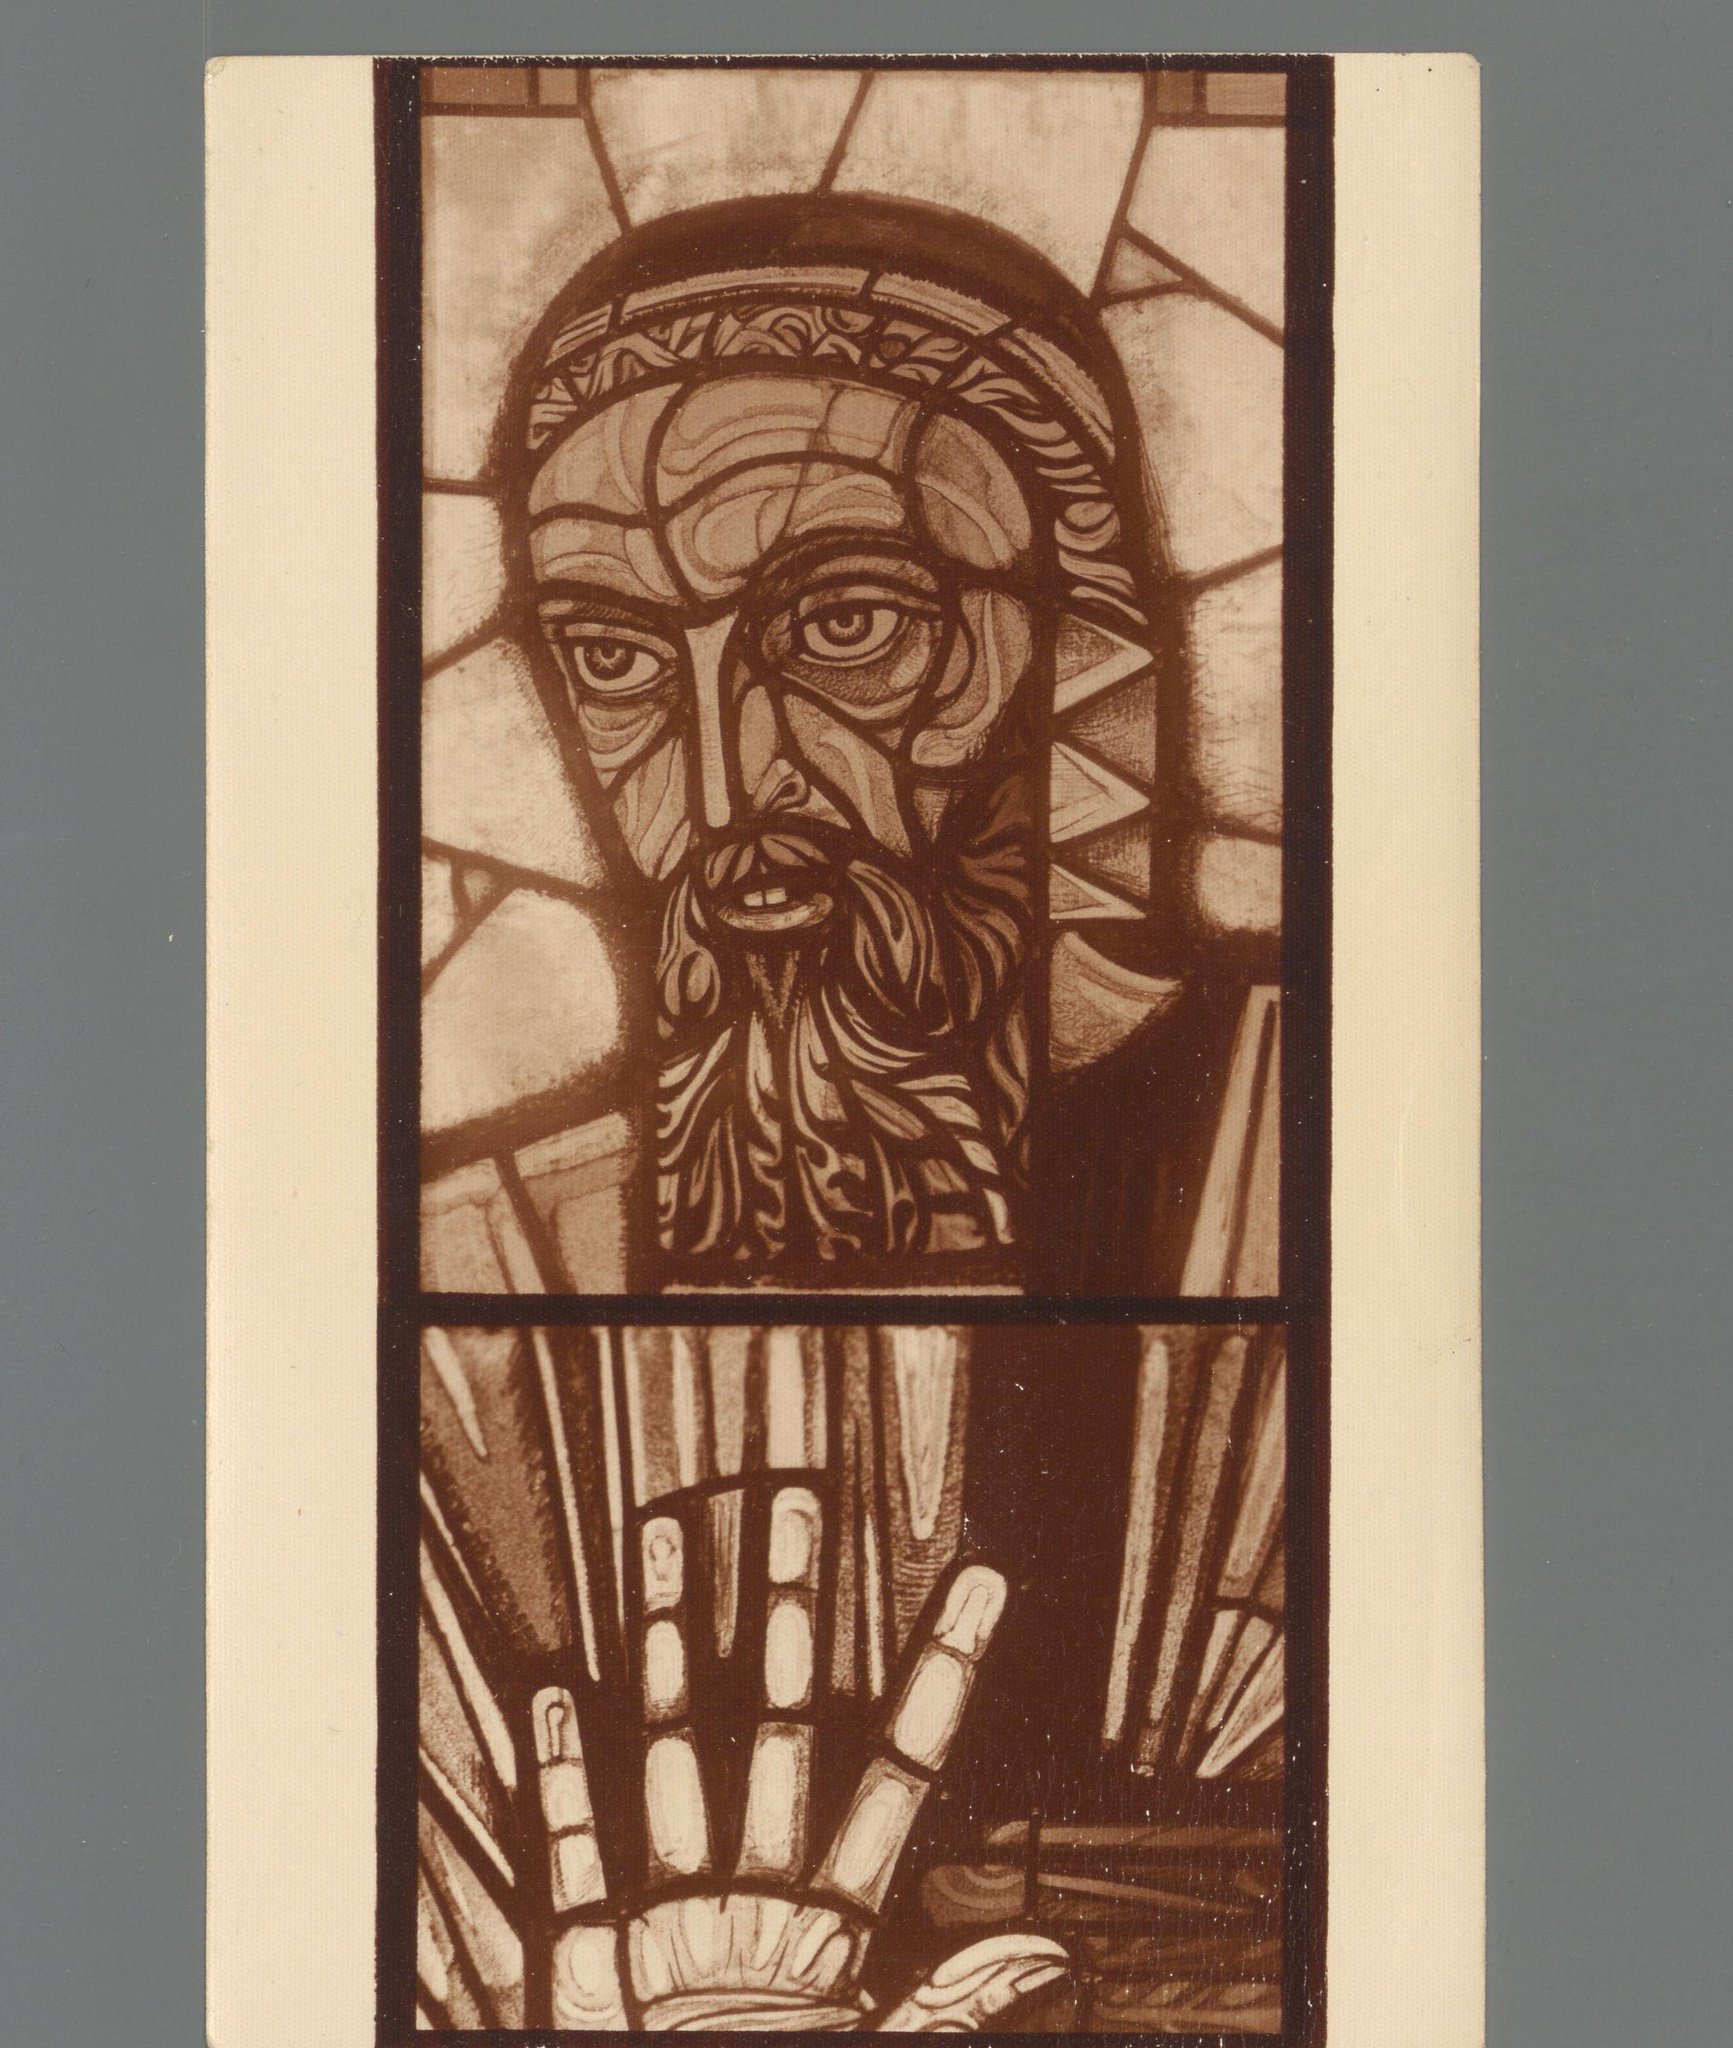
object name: ansichtkaart, prentbriefkaart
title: Evangelist Lucas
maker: Anonymous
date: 1907-1933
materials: paper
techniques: gelatin silver print, writing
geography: dresden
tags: evangelists, usually with books or scrolls (not in biblical context) - ii - the evangelists without their symbols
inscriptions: collector's mark: ‘AFE v S’